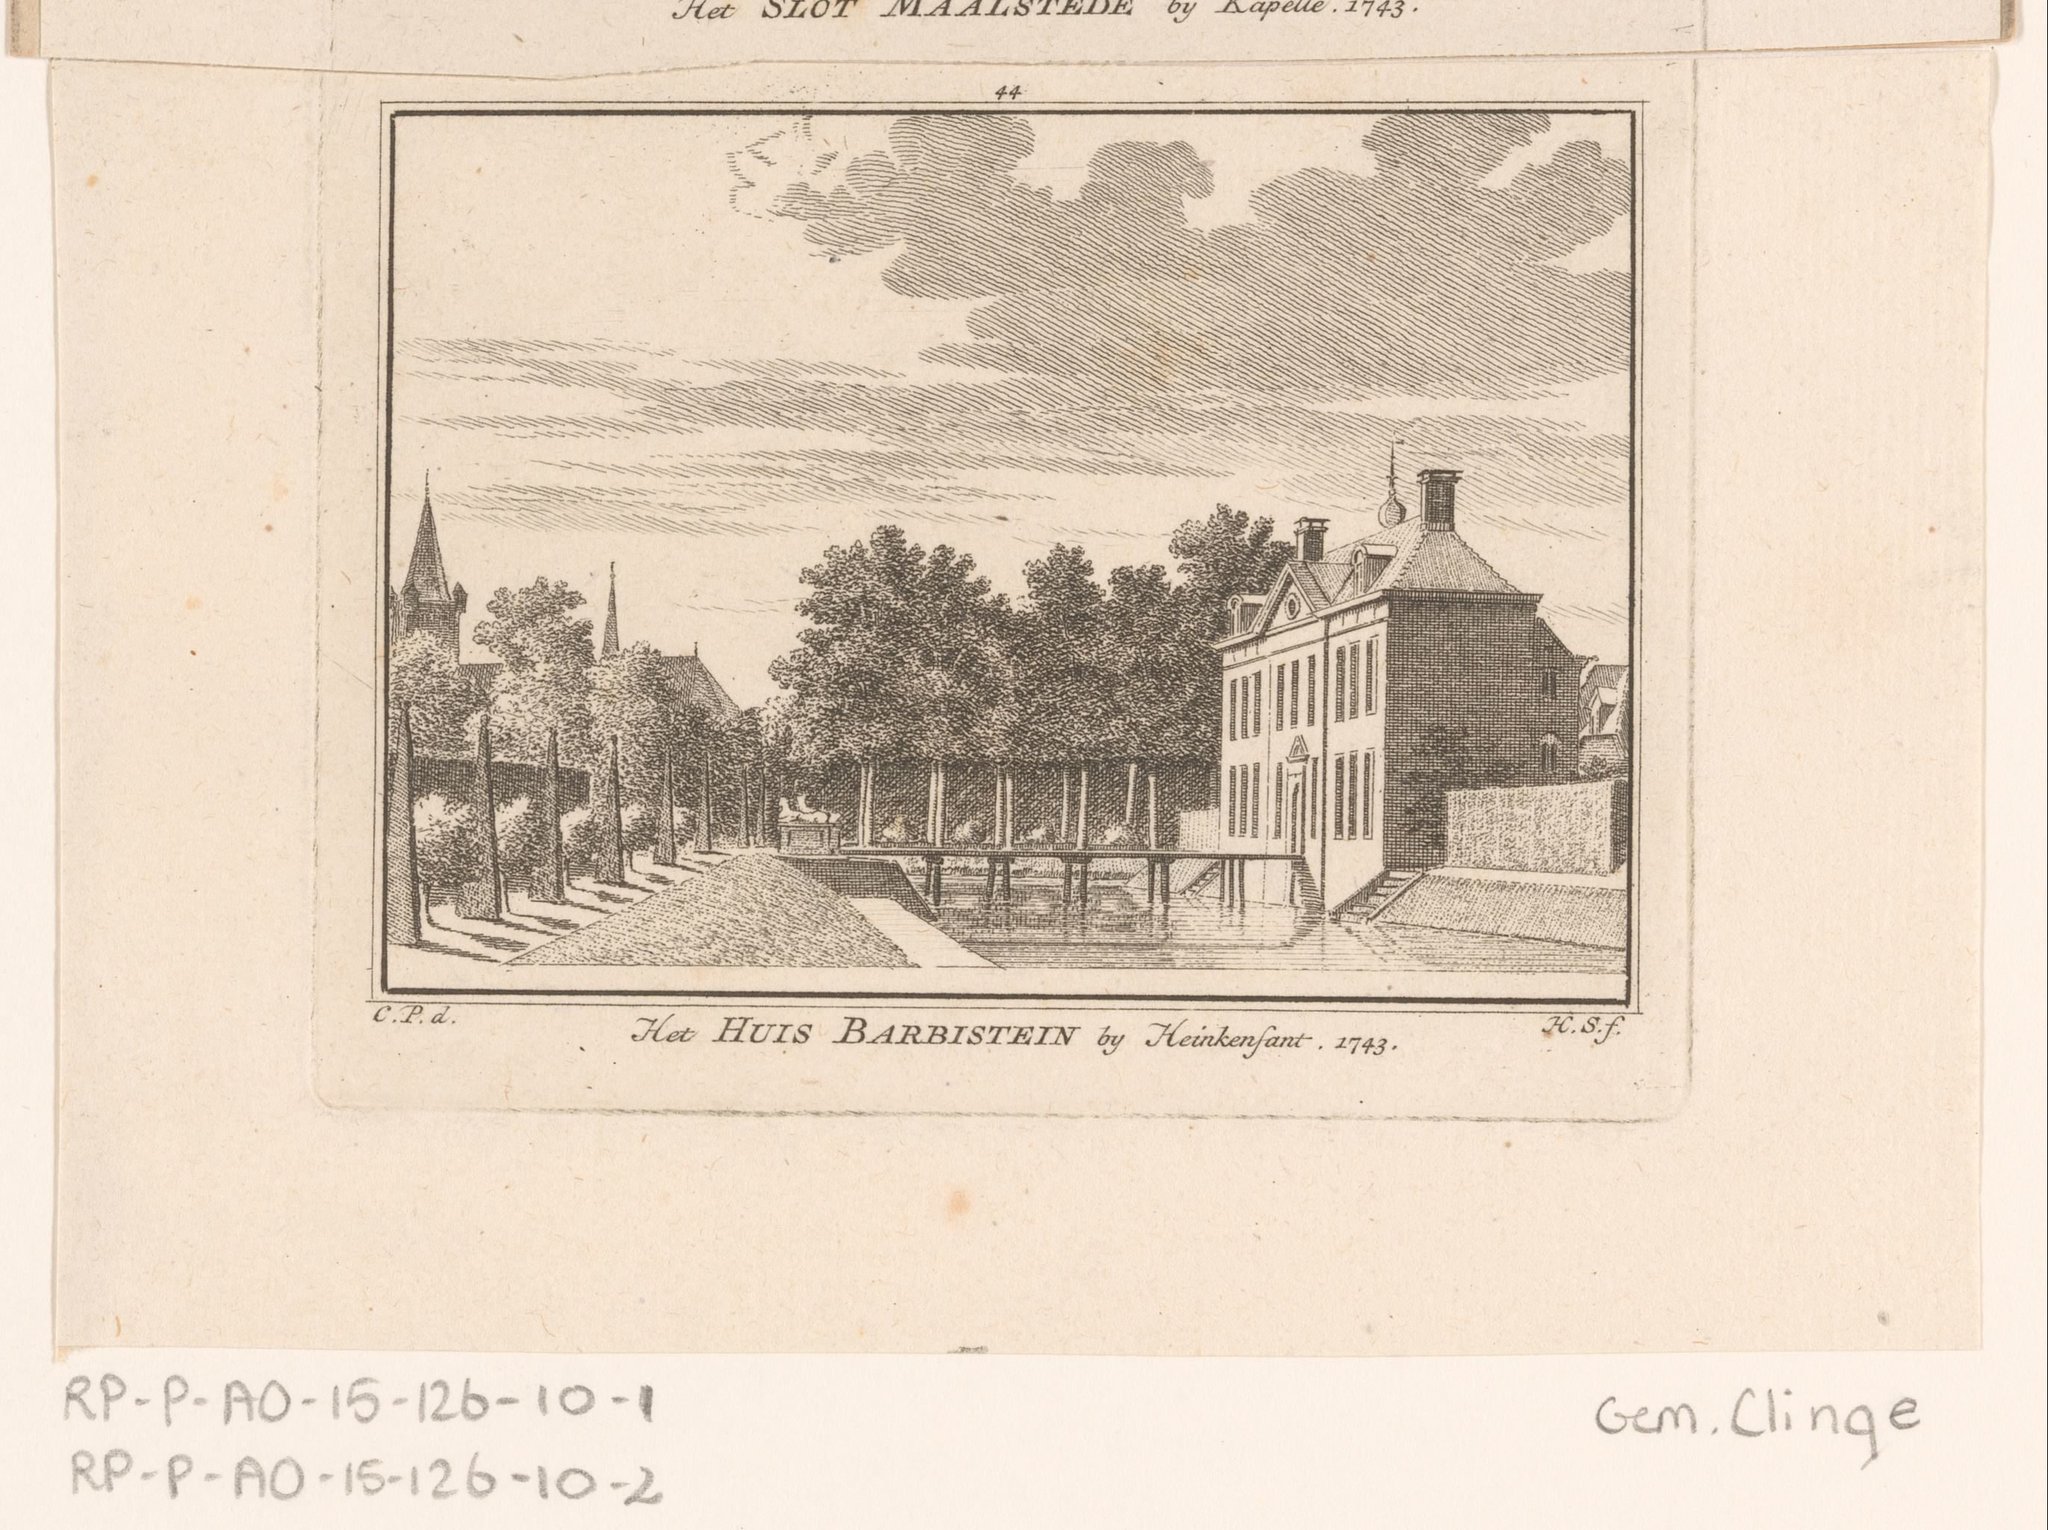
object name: book illustration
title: Het Huis Barbistein by Heinkensant. 1743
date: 1754-1792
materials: paper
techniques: etching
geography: haarlem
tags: castle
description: Prent ook gebruikt in: Het verheerlykt Nederland of kabinet van hedendaagsche gezigten van steden, dorpen (…). 9 delen. Amsterdam: Isaak Tirion en weduwe Isaak Tirion, 1745-1774, dl. 5 (1754), ill. 44. Of in: Nederlandsche tafereelen; of eene keurige verzameling van negen honderd fraaije gezigten van steden, dorpen, sloten, oudheden [….]. 9 delen. Amsterdam: Jan de Groot, 1792, dl. 5, ill. 44.